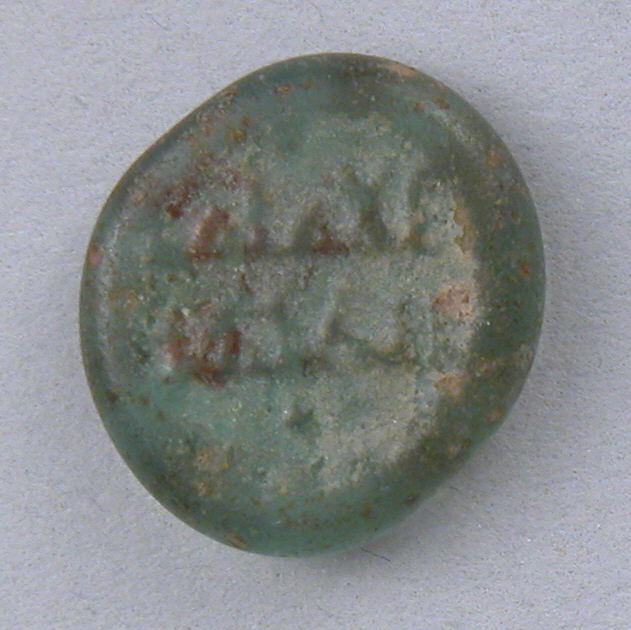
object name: coin weight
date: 1001-1100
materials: glass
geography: egypt